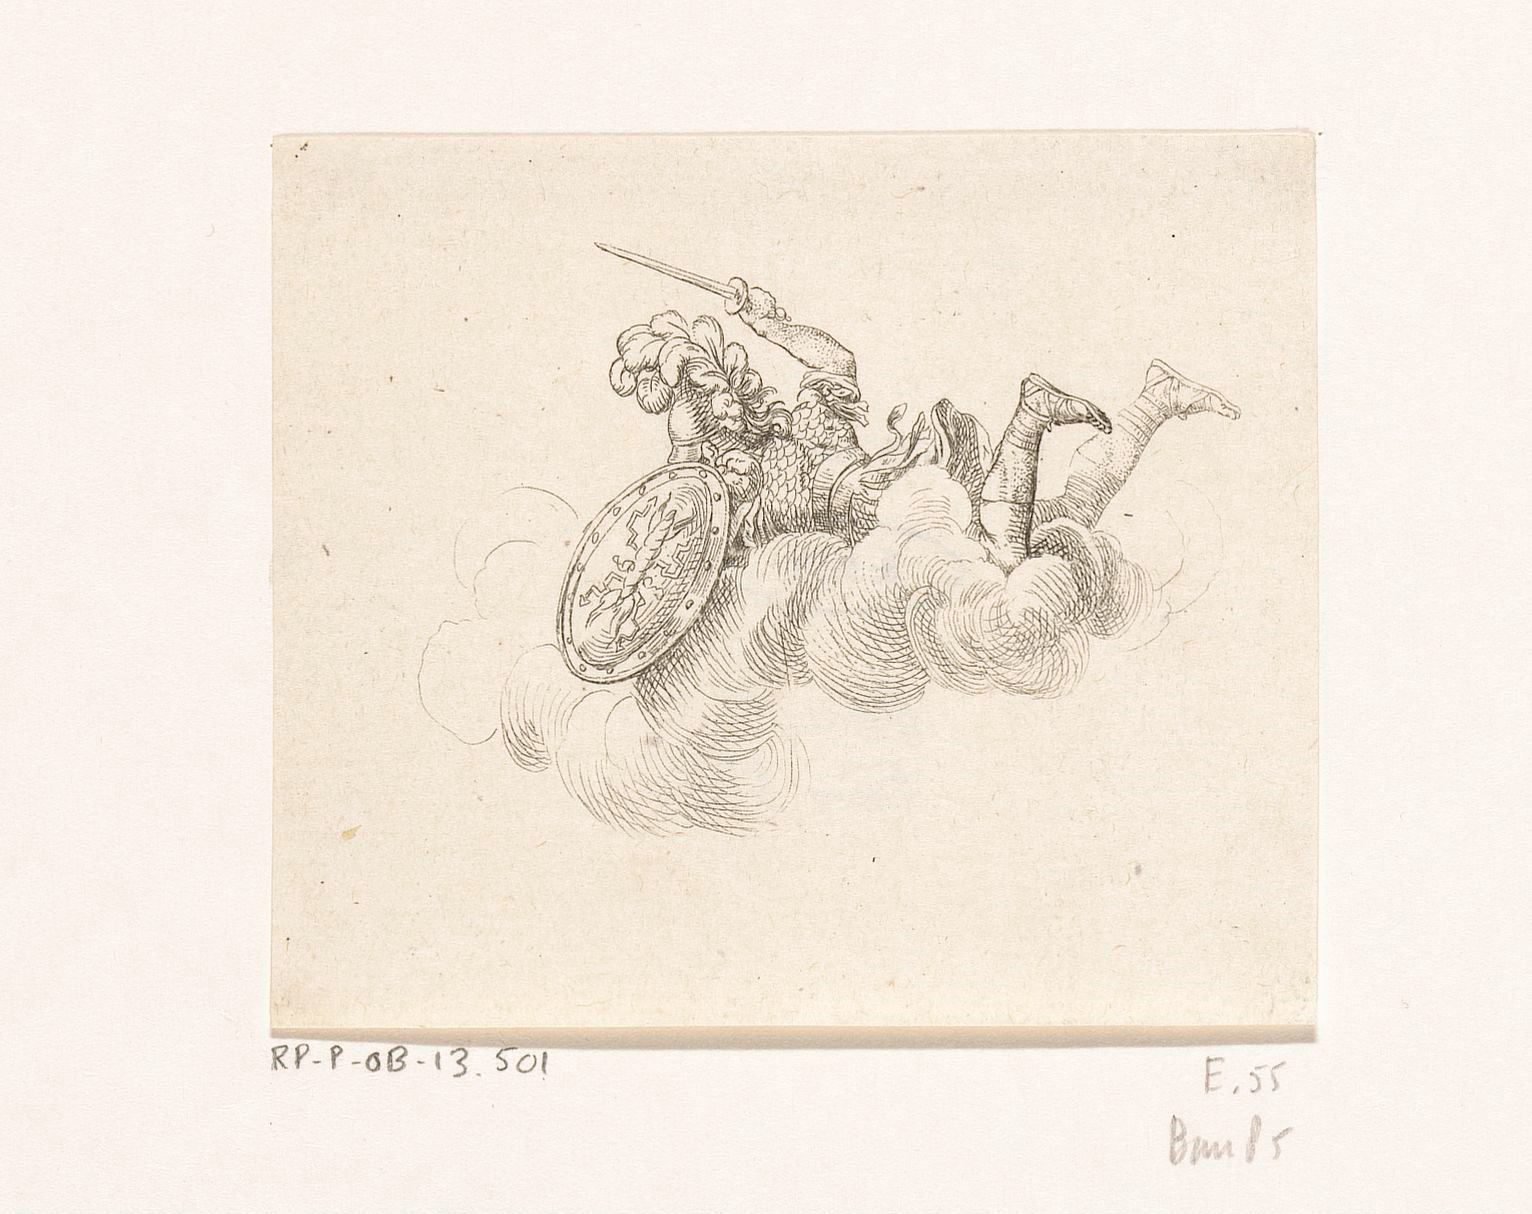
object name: print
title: Mars in de wolken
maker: daniel nikolaus chodowiecki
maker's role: draughtsman, print maker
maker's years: 1726-1801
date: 1769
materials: paper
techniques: etching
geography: berlin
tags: (story of) mars (ares)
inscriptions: collector's mark: Lugt 2228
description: Deze prent omvat het linkerdeel van de koperplaat met daarop Mars en Venus (zie RP-P-OB-13.502). Er zijn afdrukken bekend van de tweede staat van 'Prins Golitsyn met gevangengenomen Turkse vrouwen voor de vesting van Chotyn, 1769' (vergelijk RP-P-OB-13.500) waarbij deze koperplaat gebruikt is om Mars en Venus in de lucht te drukken. In de eerste staat hadden deze hier ook gestaan, maar wegens beschadigingen waren zij in de tweede staat weggeslepen.